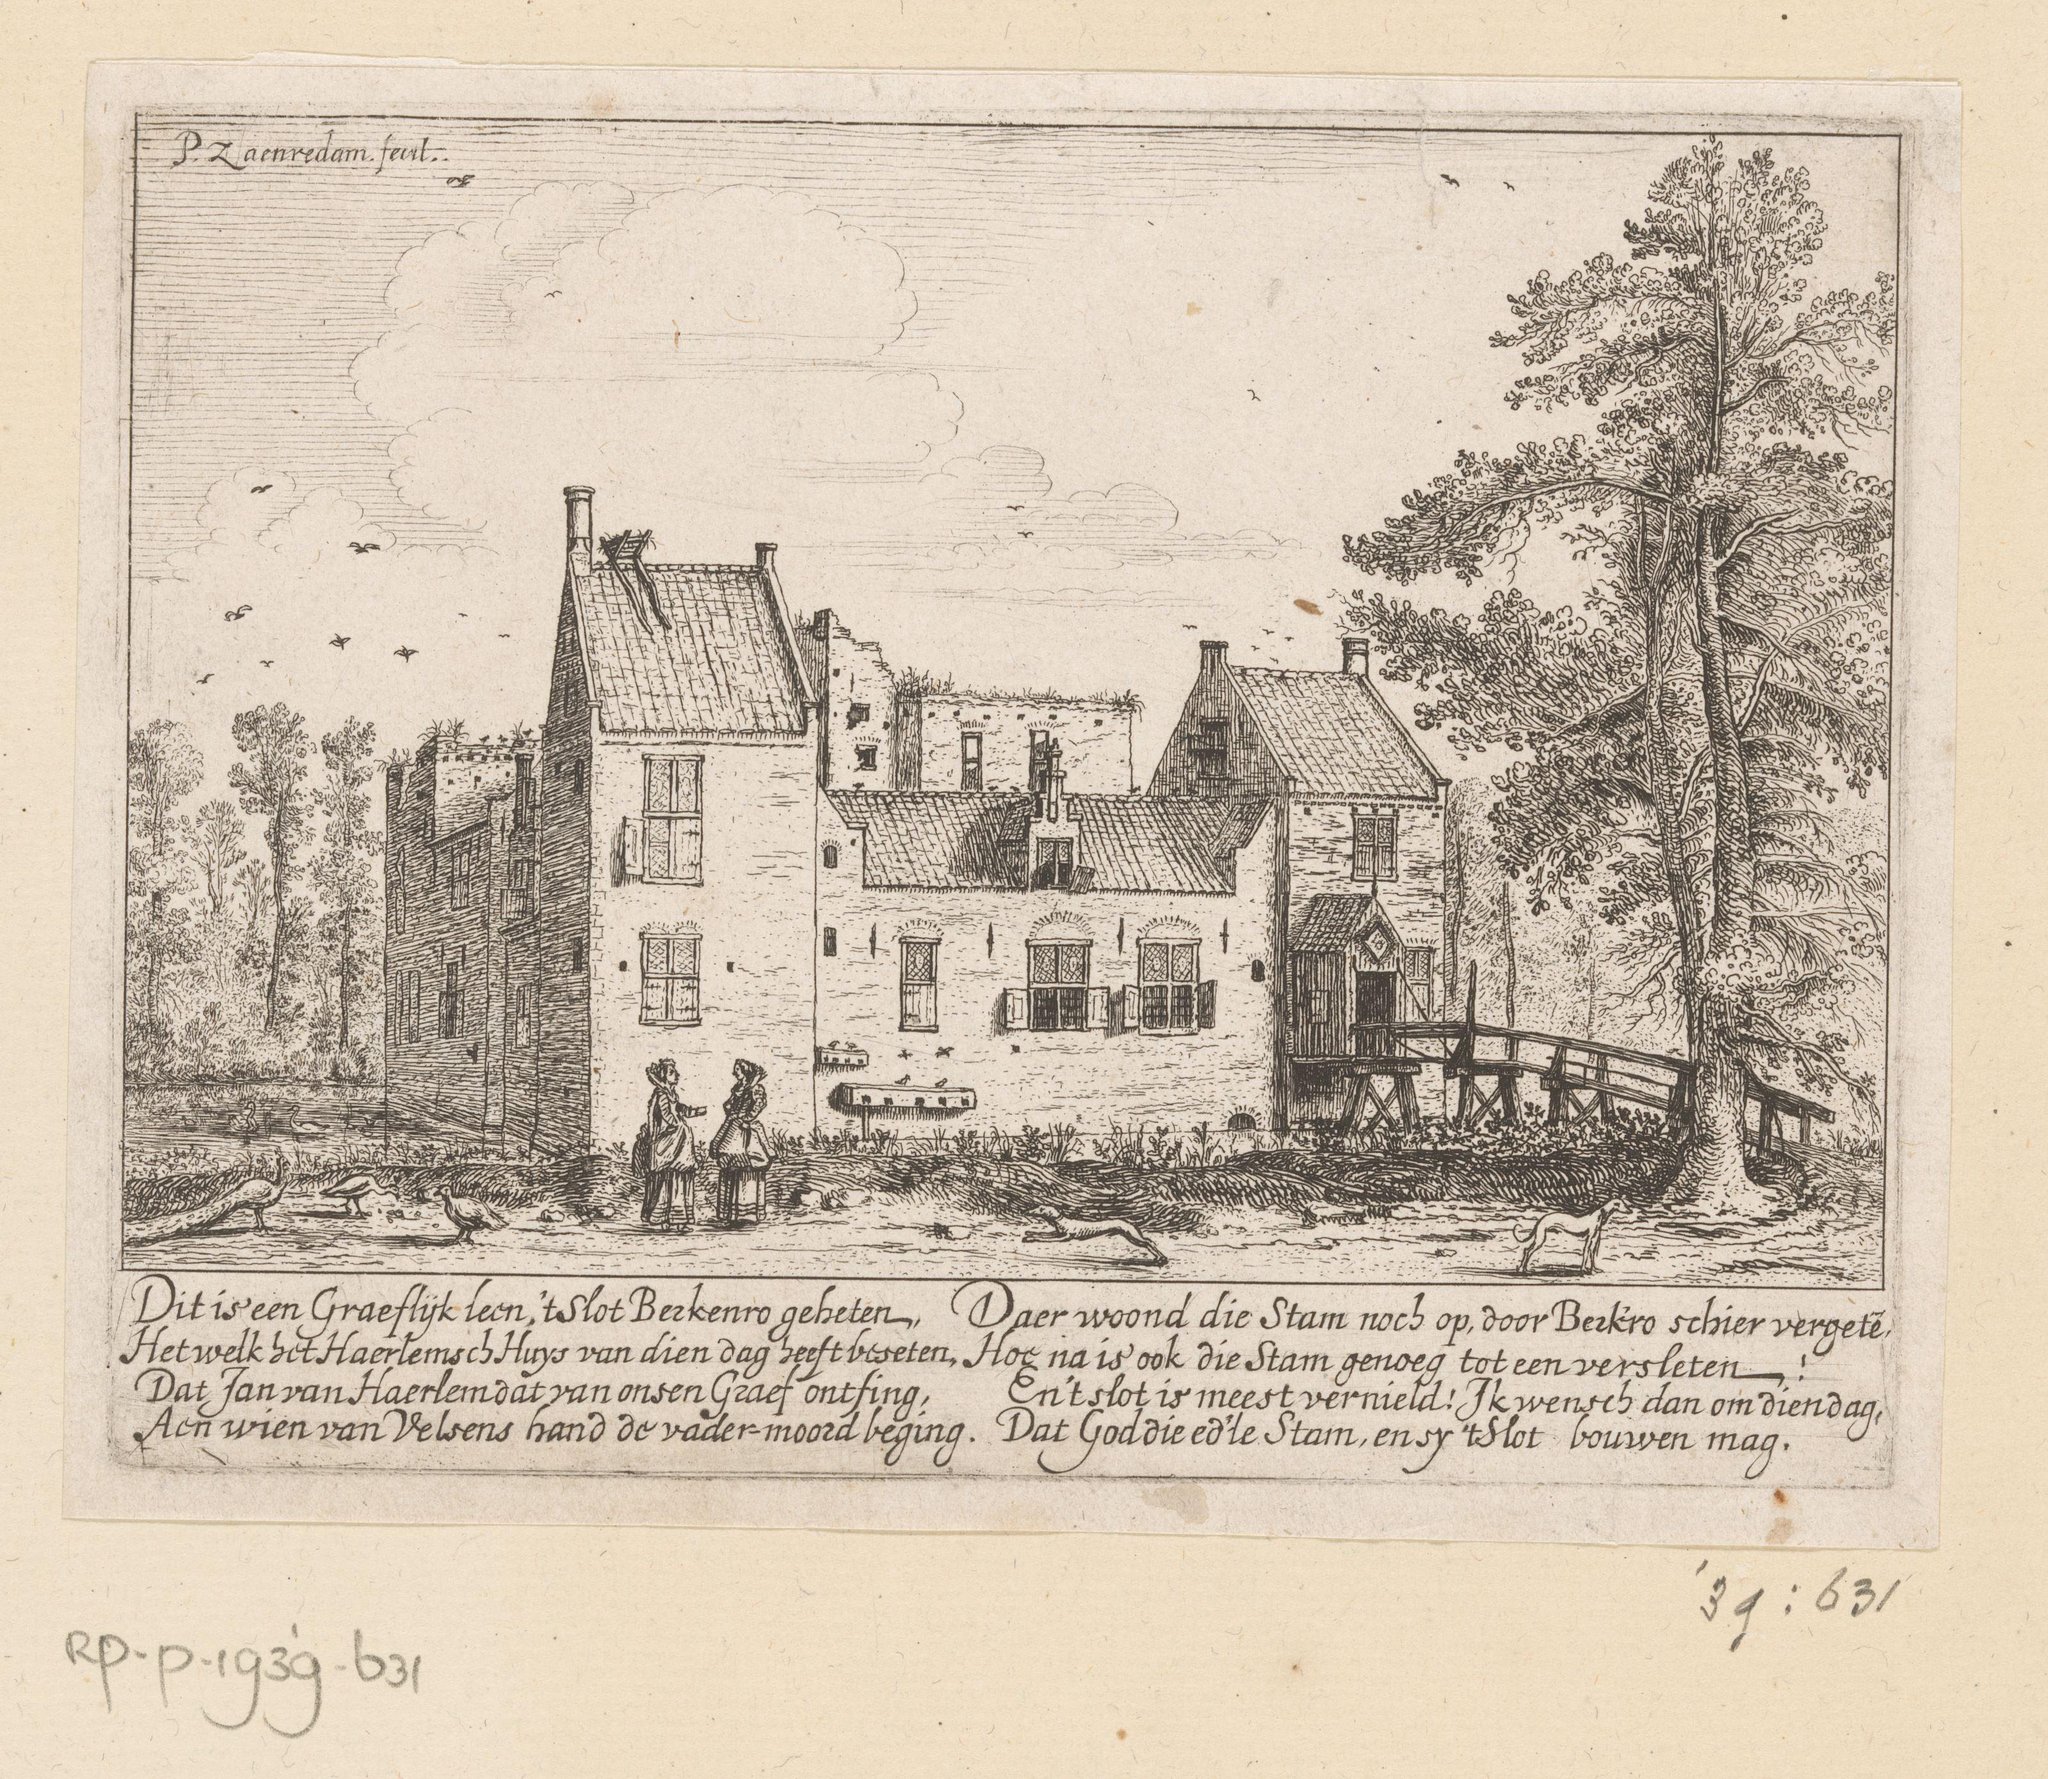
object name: print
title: Dit is'eengraefllijk leen, 't Slot Berkenro geheten (...)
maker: pieter jansz saenredam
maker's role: draughtsman, painter, print maker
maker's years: 1597-1665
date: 1607-1665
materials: paper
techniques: etching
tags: drawbridge ~ fortified city, castle, ornamental birds: peacock, dog (with name of kind)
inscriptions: collector's mark: Lugt 2760, collector's mark: Lugt 2166